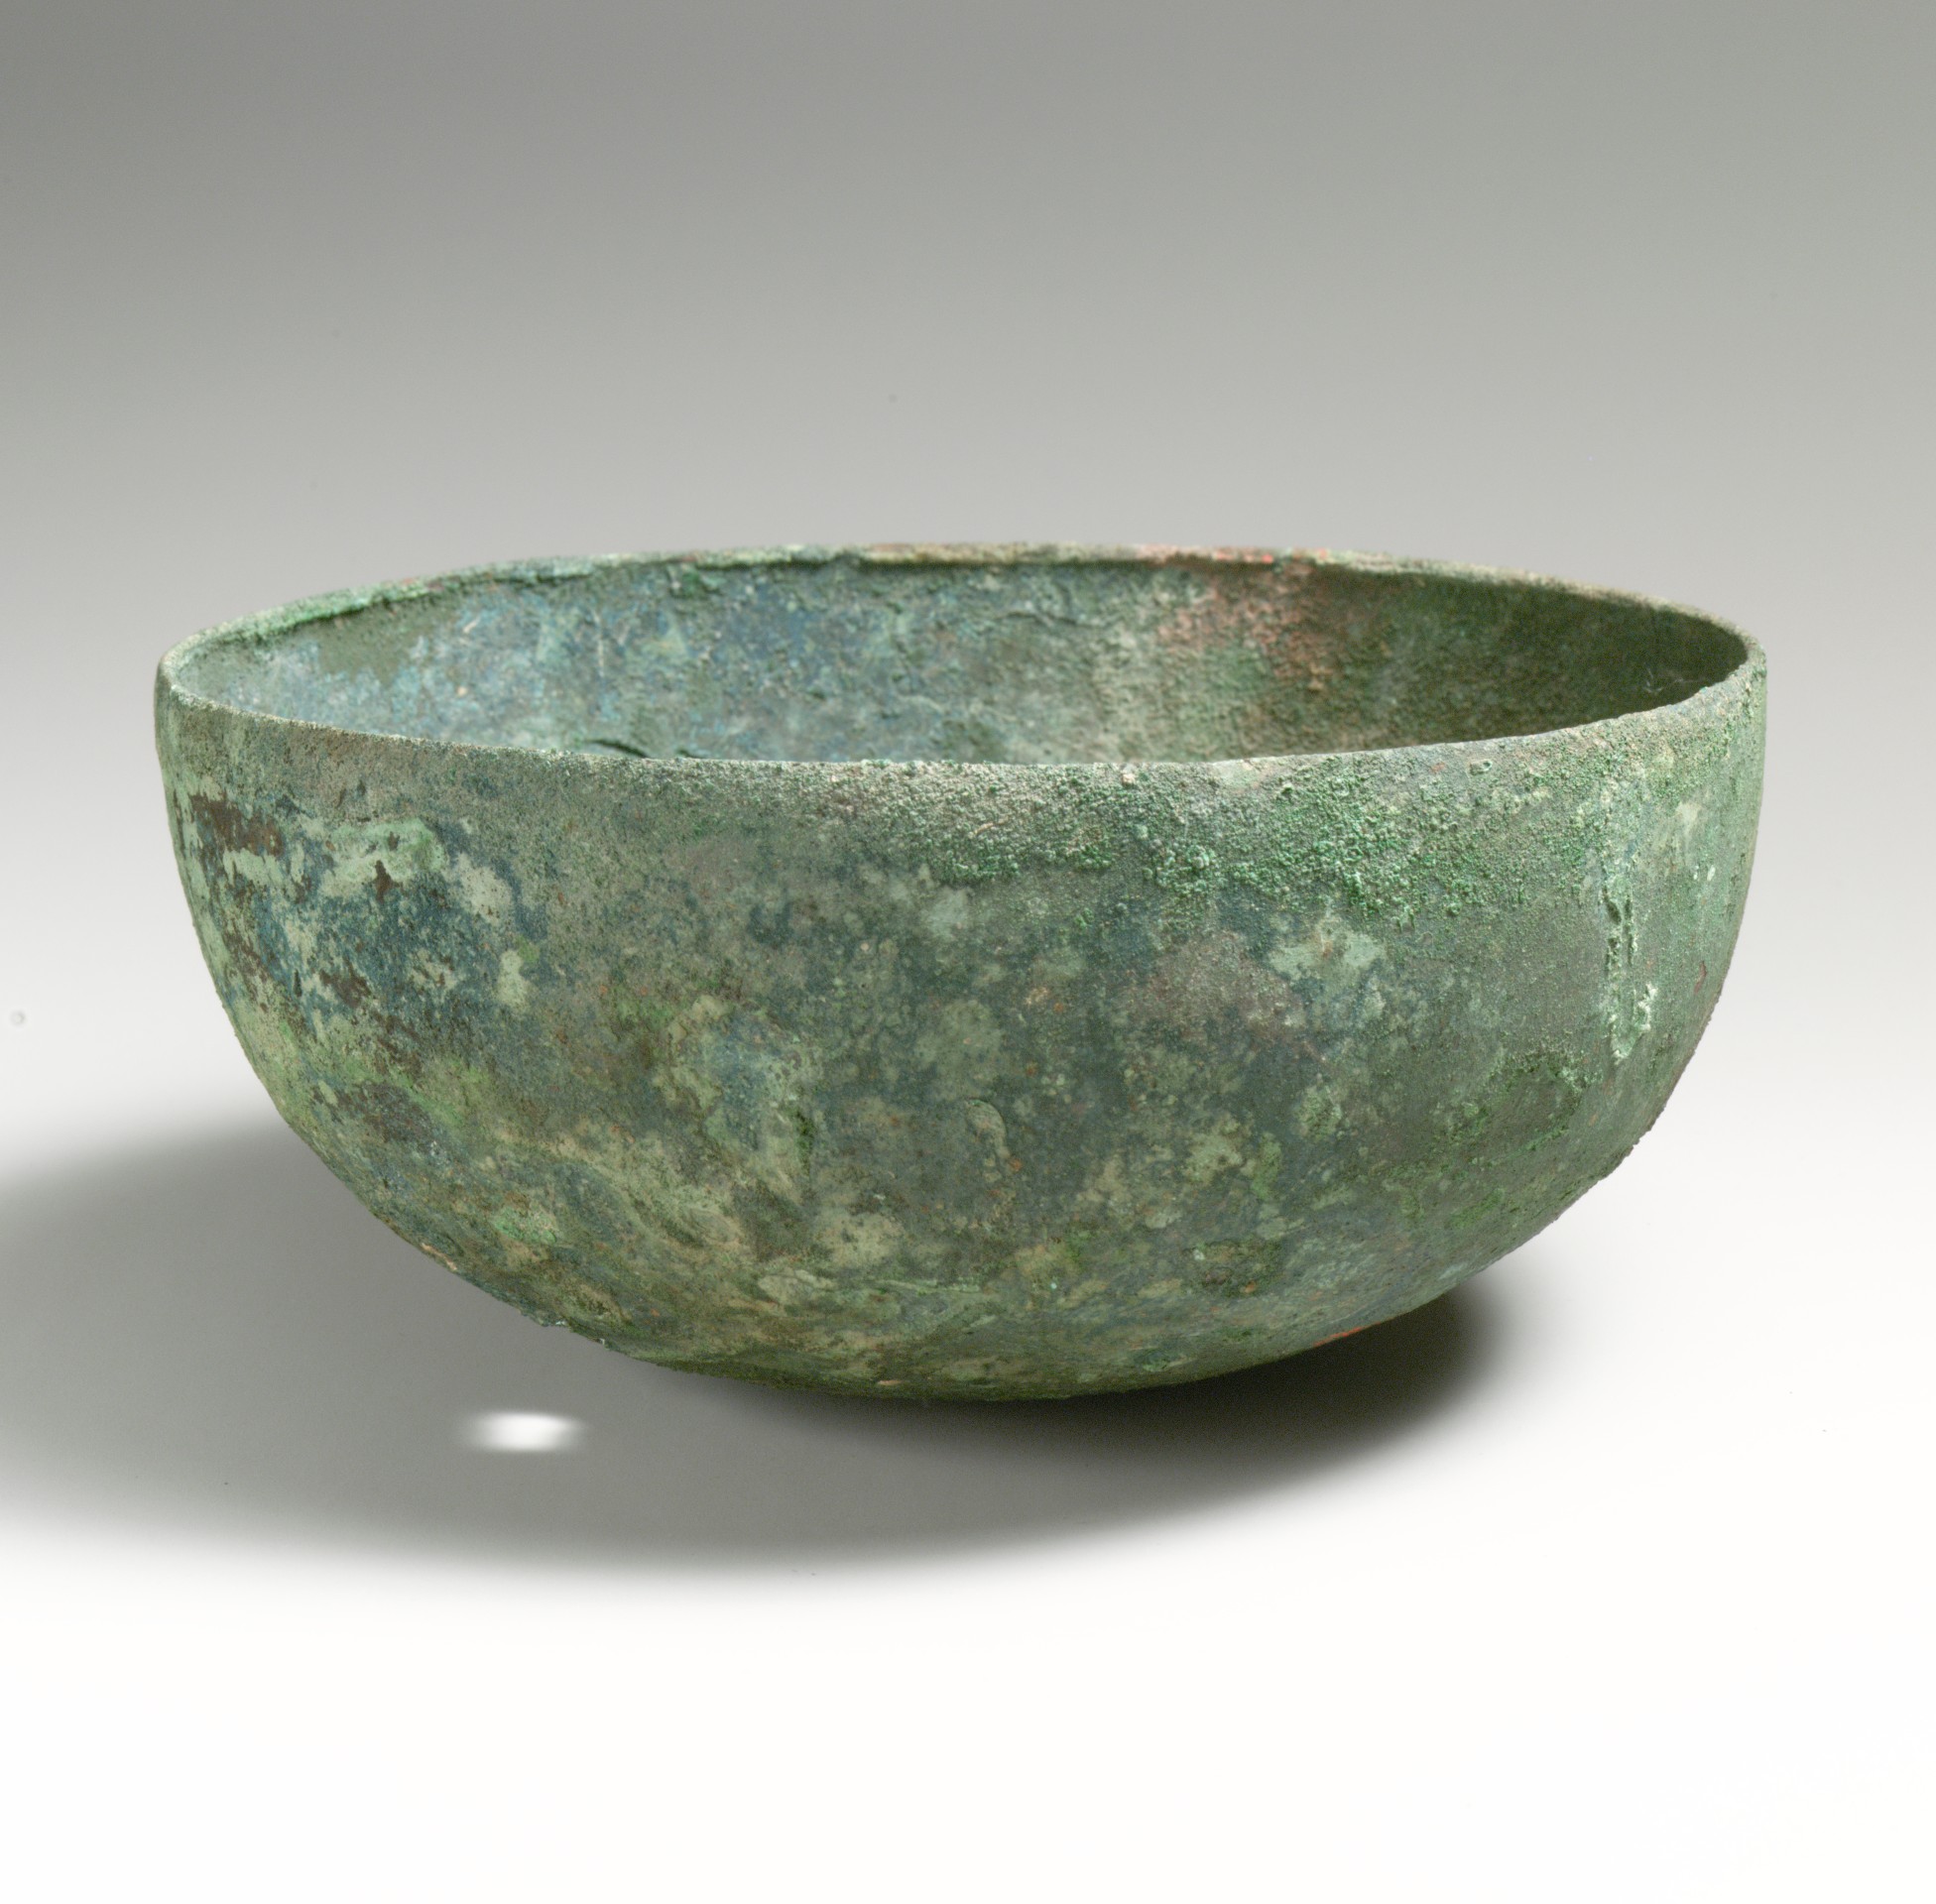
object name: bowl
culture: cypriot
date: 3900 BCE-100 CE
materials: bronze